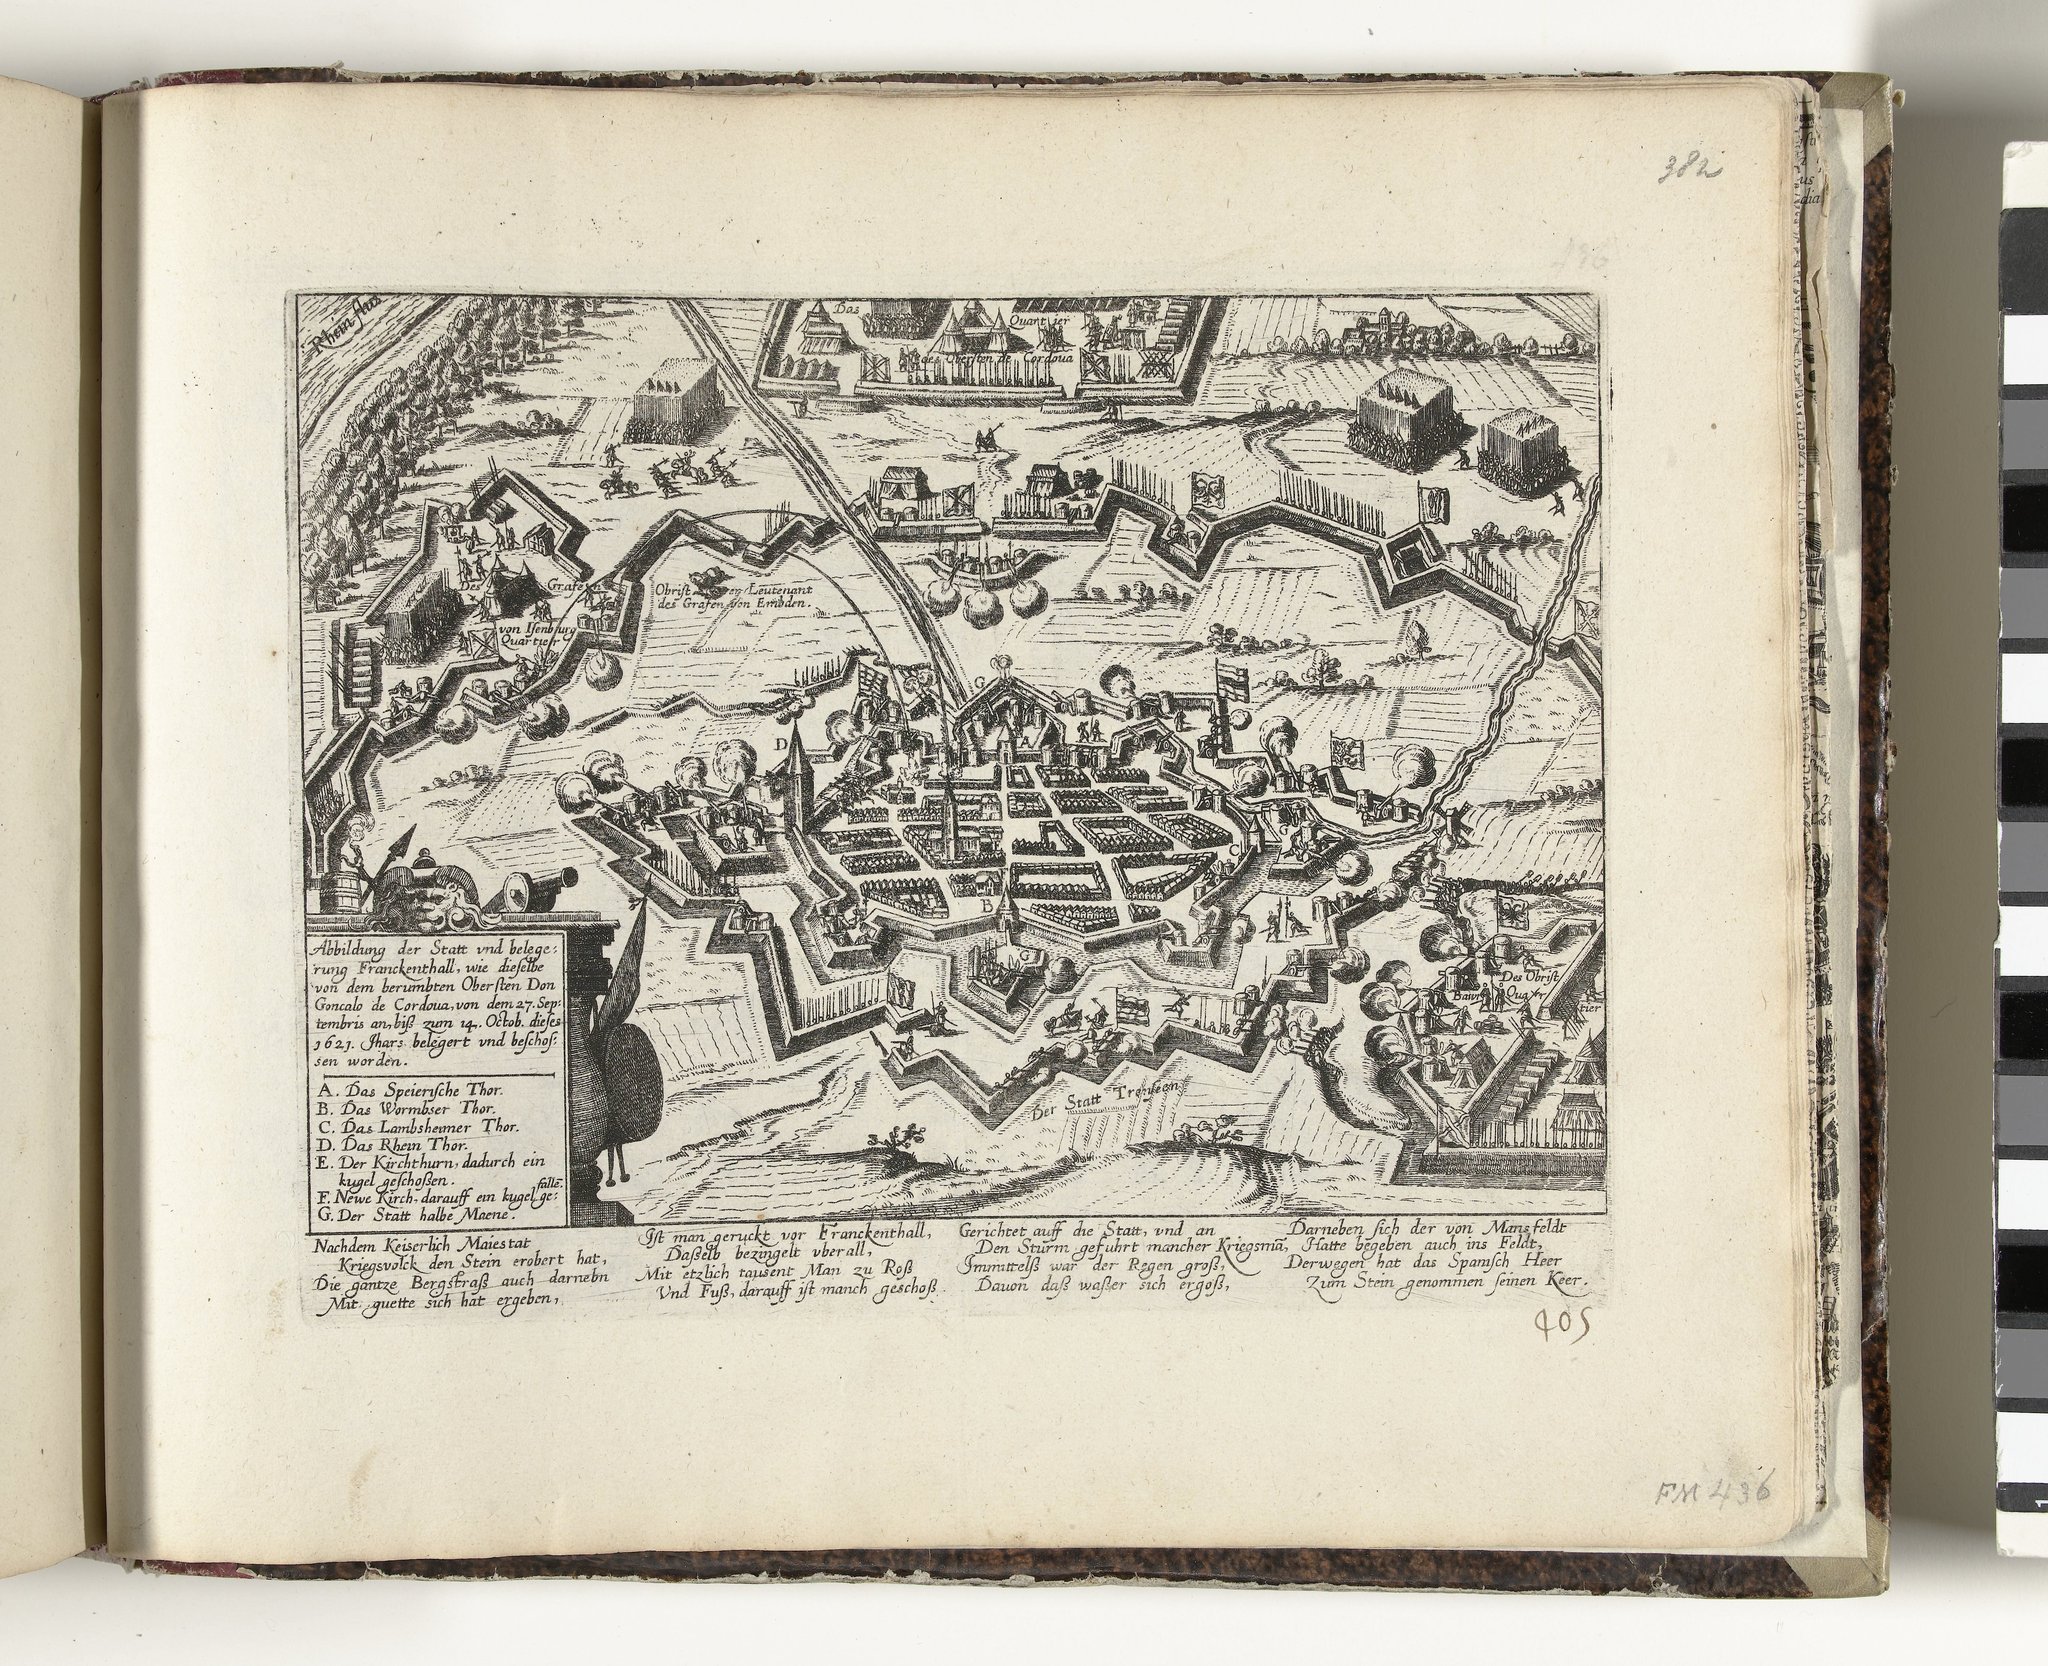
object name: print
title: Beleg van Frankenthal door de Spanjaarden, 1621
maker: frans hogenberg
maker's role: print maker, publisher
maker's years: 1538-1590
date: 1621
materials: paper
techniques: etching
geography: cologne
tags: siege, position war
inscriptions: inscription: ‘405’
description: Beleg van Frankenthal door de Spanjaarden onder Gonzalvo van Cordova, vanaf 21 september tot 14 oktober 1621. Met legenda A-G en onderschrift van 16 regels in het Duits. Rechtsonder met pen genummerd: 405. De prent maakt deel uit van een album.